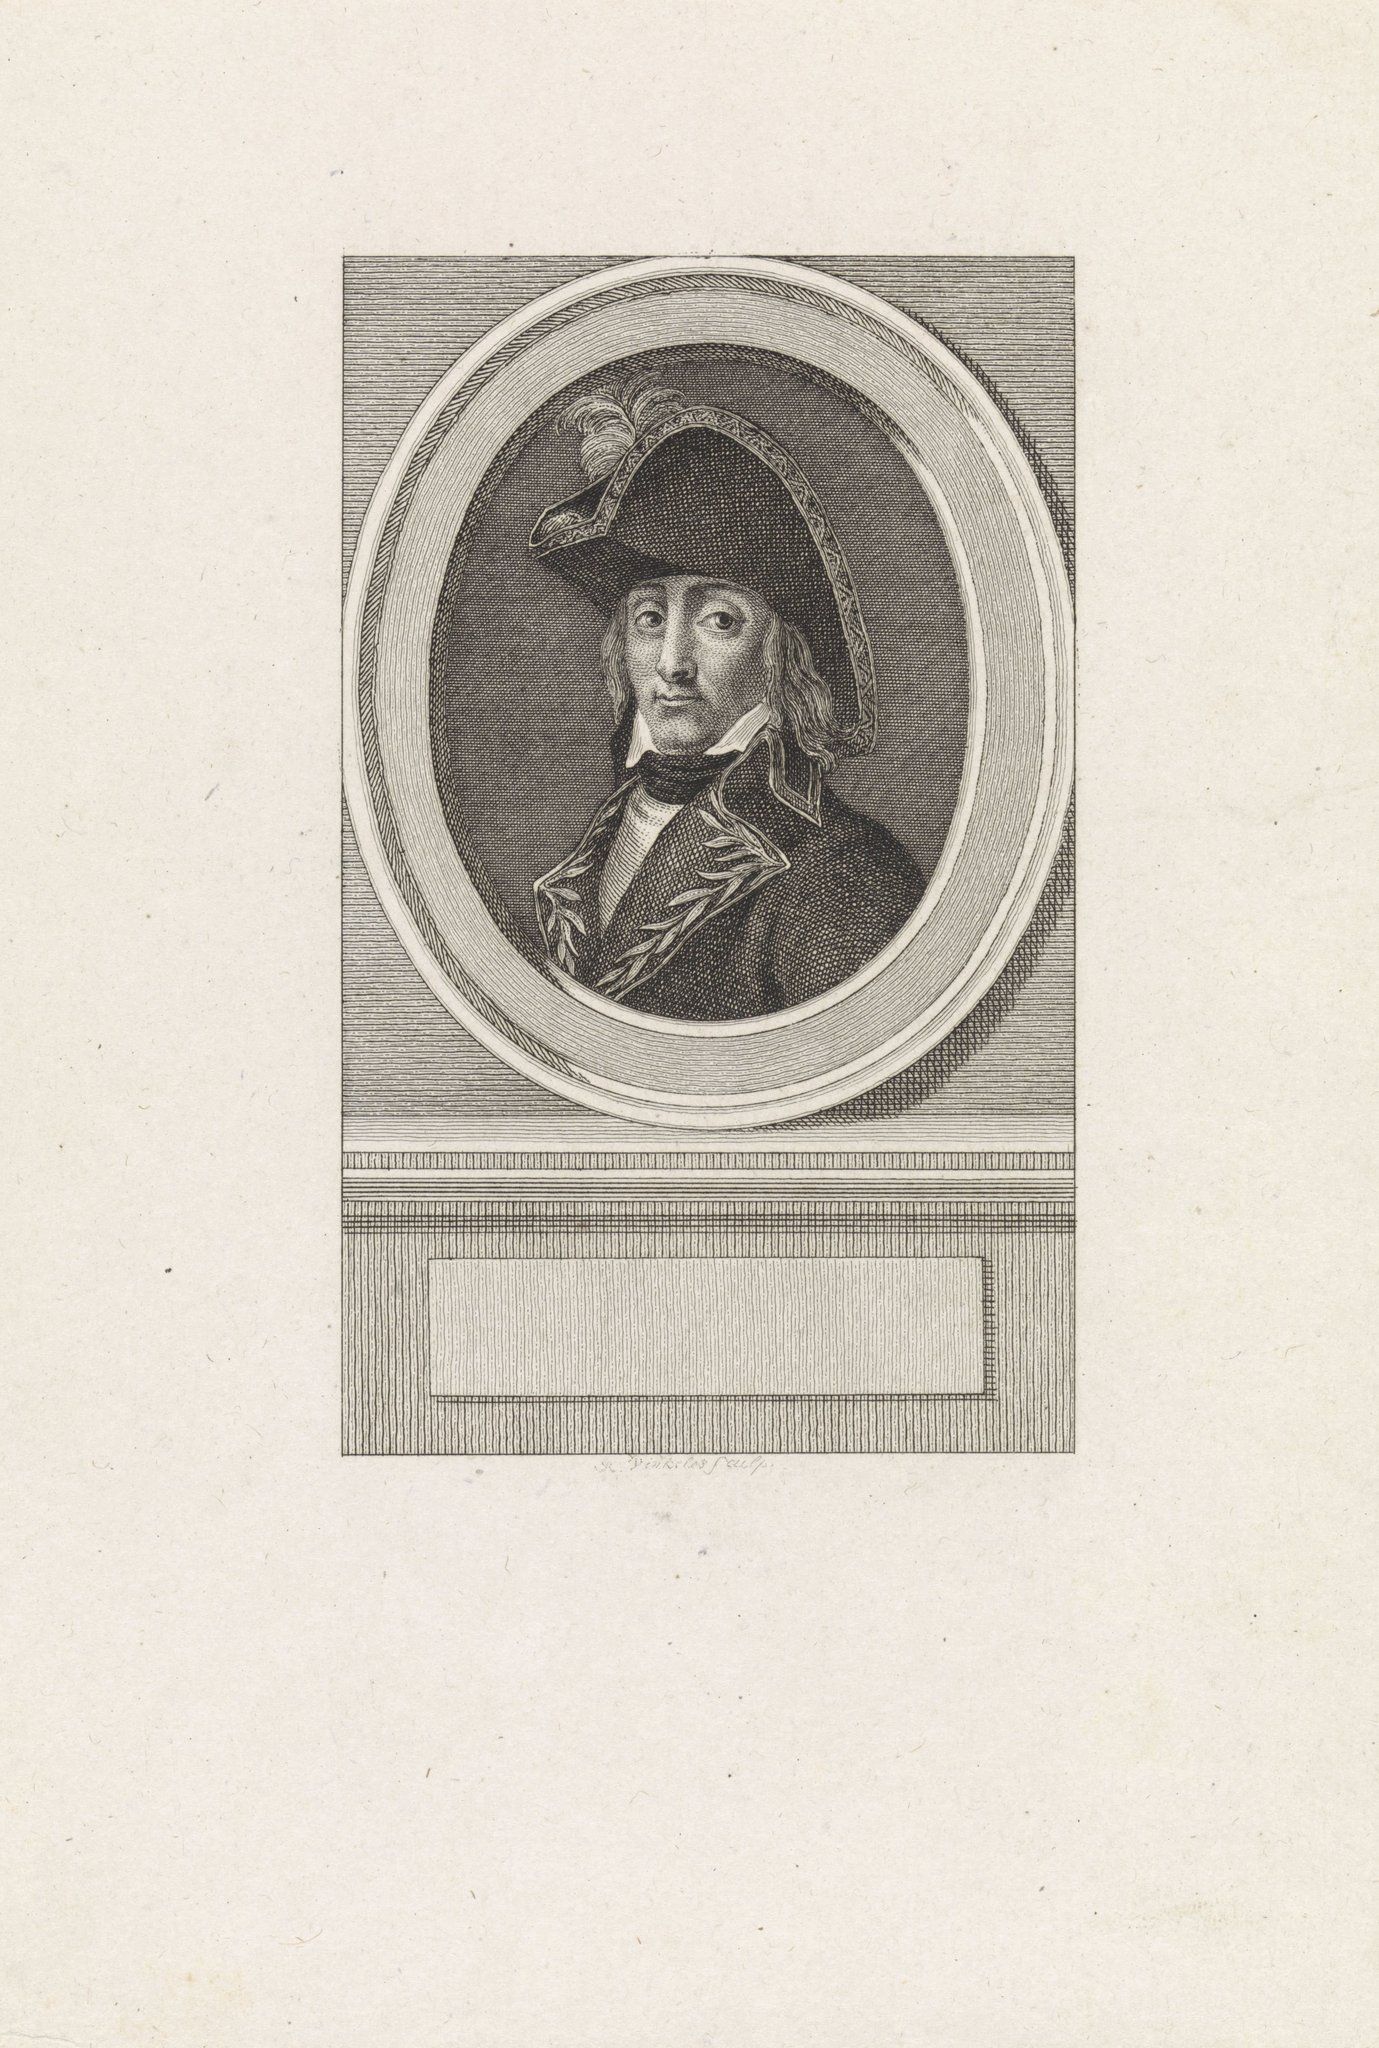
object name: print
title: Portret van Pierre François Charles Augereau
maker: reinier vinkeles (i)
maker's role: draughtsman, print maker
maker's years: 1741-1816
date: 1751-1816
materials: paper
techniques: engraving, etching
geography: amsterdam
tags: paris, politician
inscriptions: collector's mark: Lugt 2228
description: Portret van de Franse maarschalk Pierre François Charles Augereau.